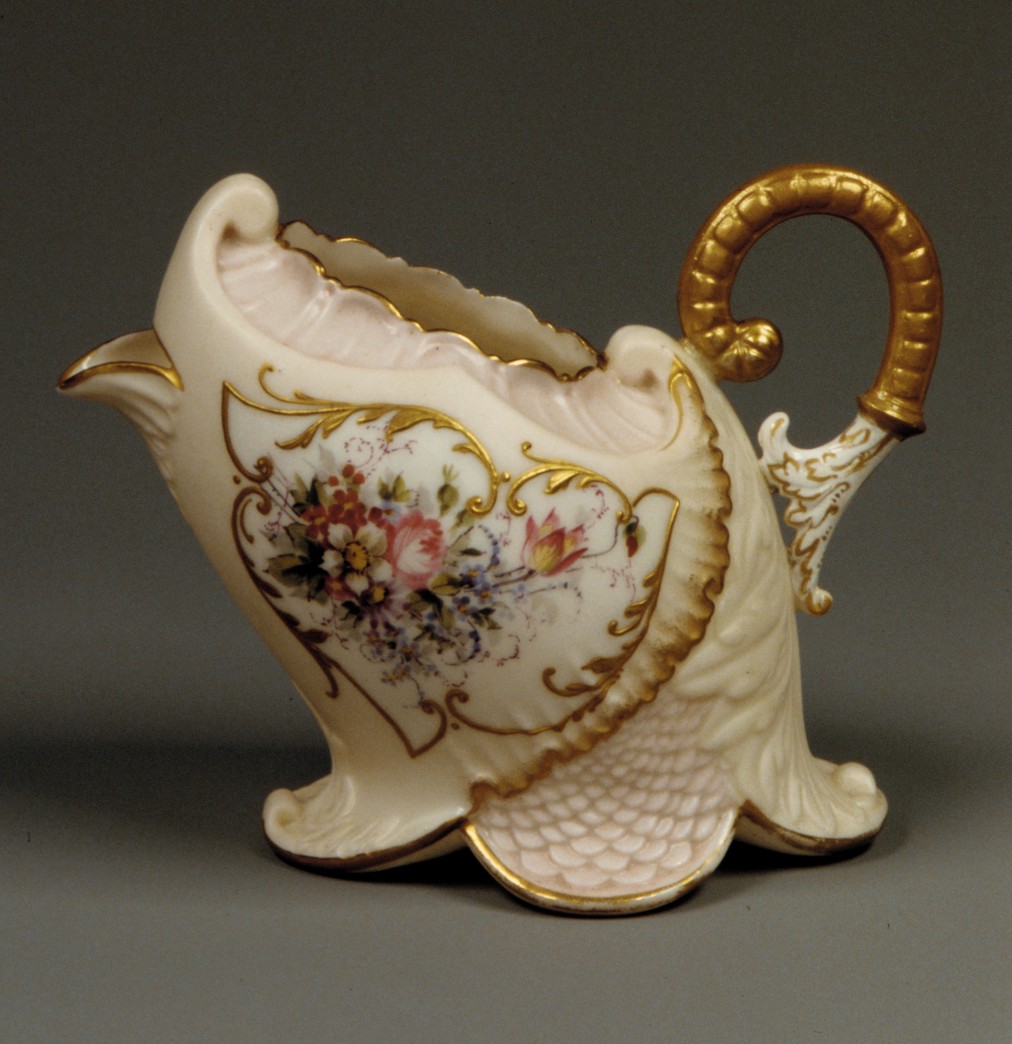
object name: cream pot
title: Creamer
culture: american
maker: american art china company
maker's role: maker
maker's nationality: american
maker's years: 1891-1894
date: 1891-1894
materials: porcelain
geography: united states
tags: flowers